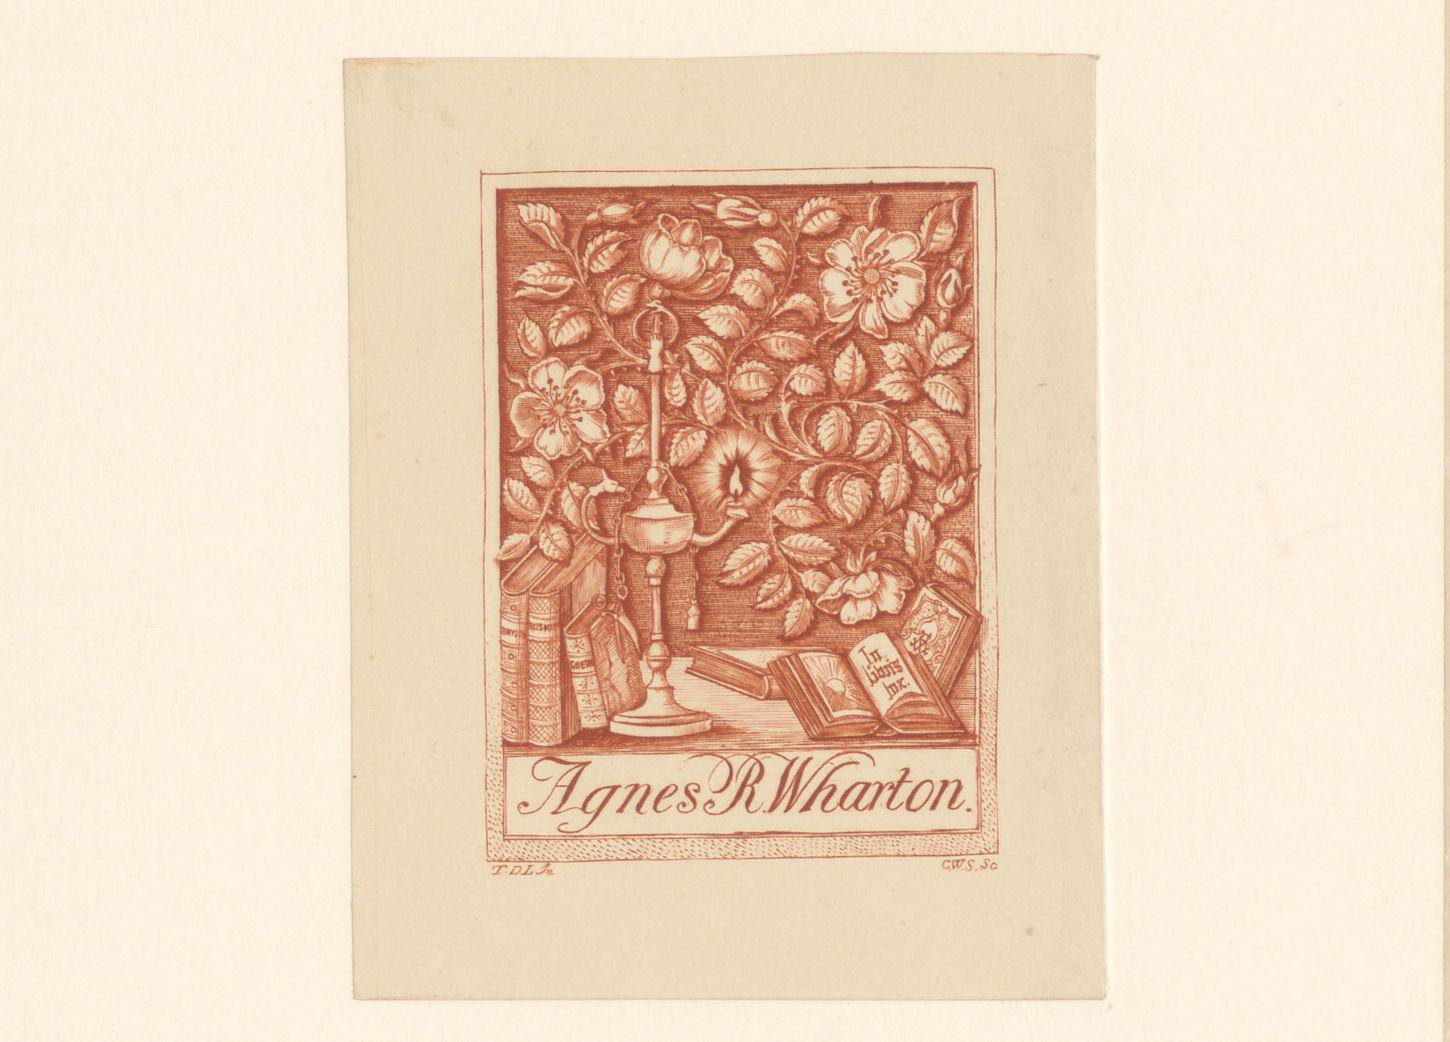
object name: bookplate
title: Ex libris van Agnes R. Wharton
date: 1841-1912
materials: paper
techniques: engraving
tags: flowers, foliage ~ ornament, oil-lamp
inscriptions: collector's mark: Lugt 2228